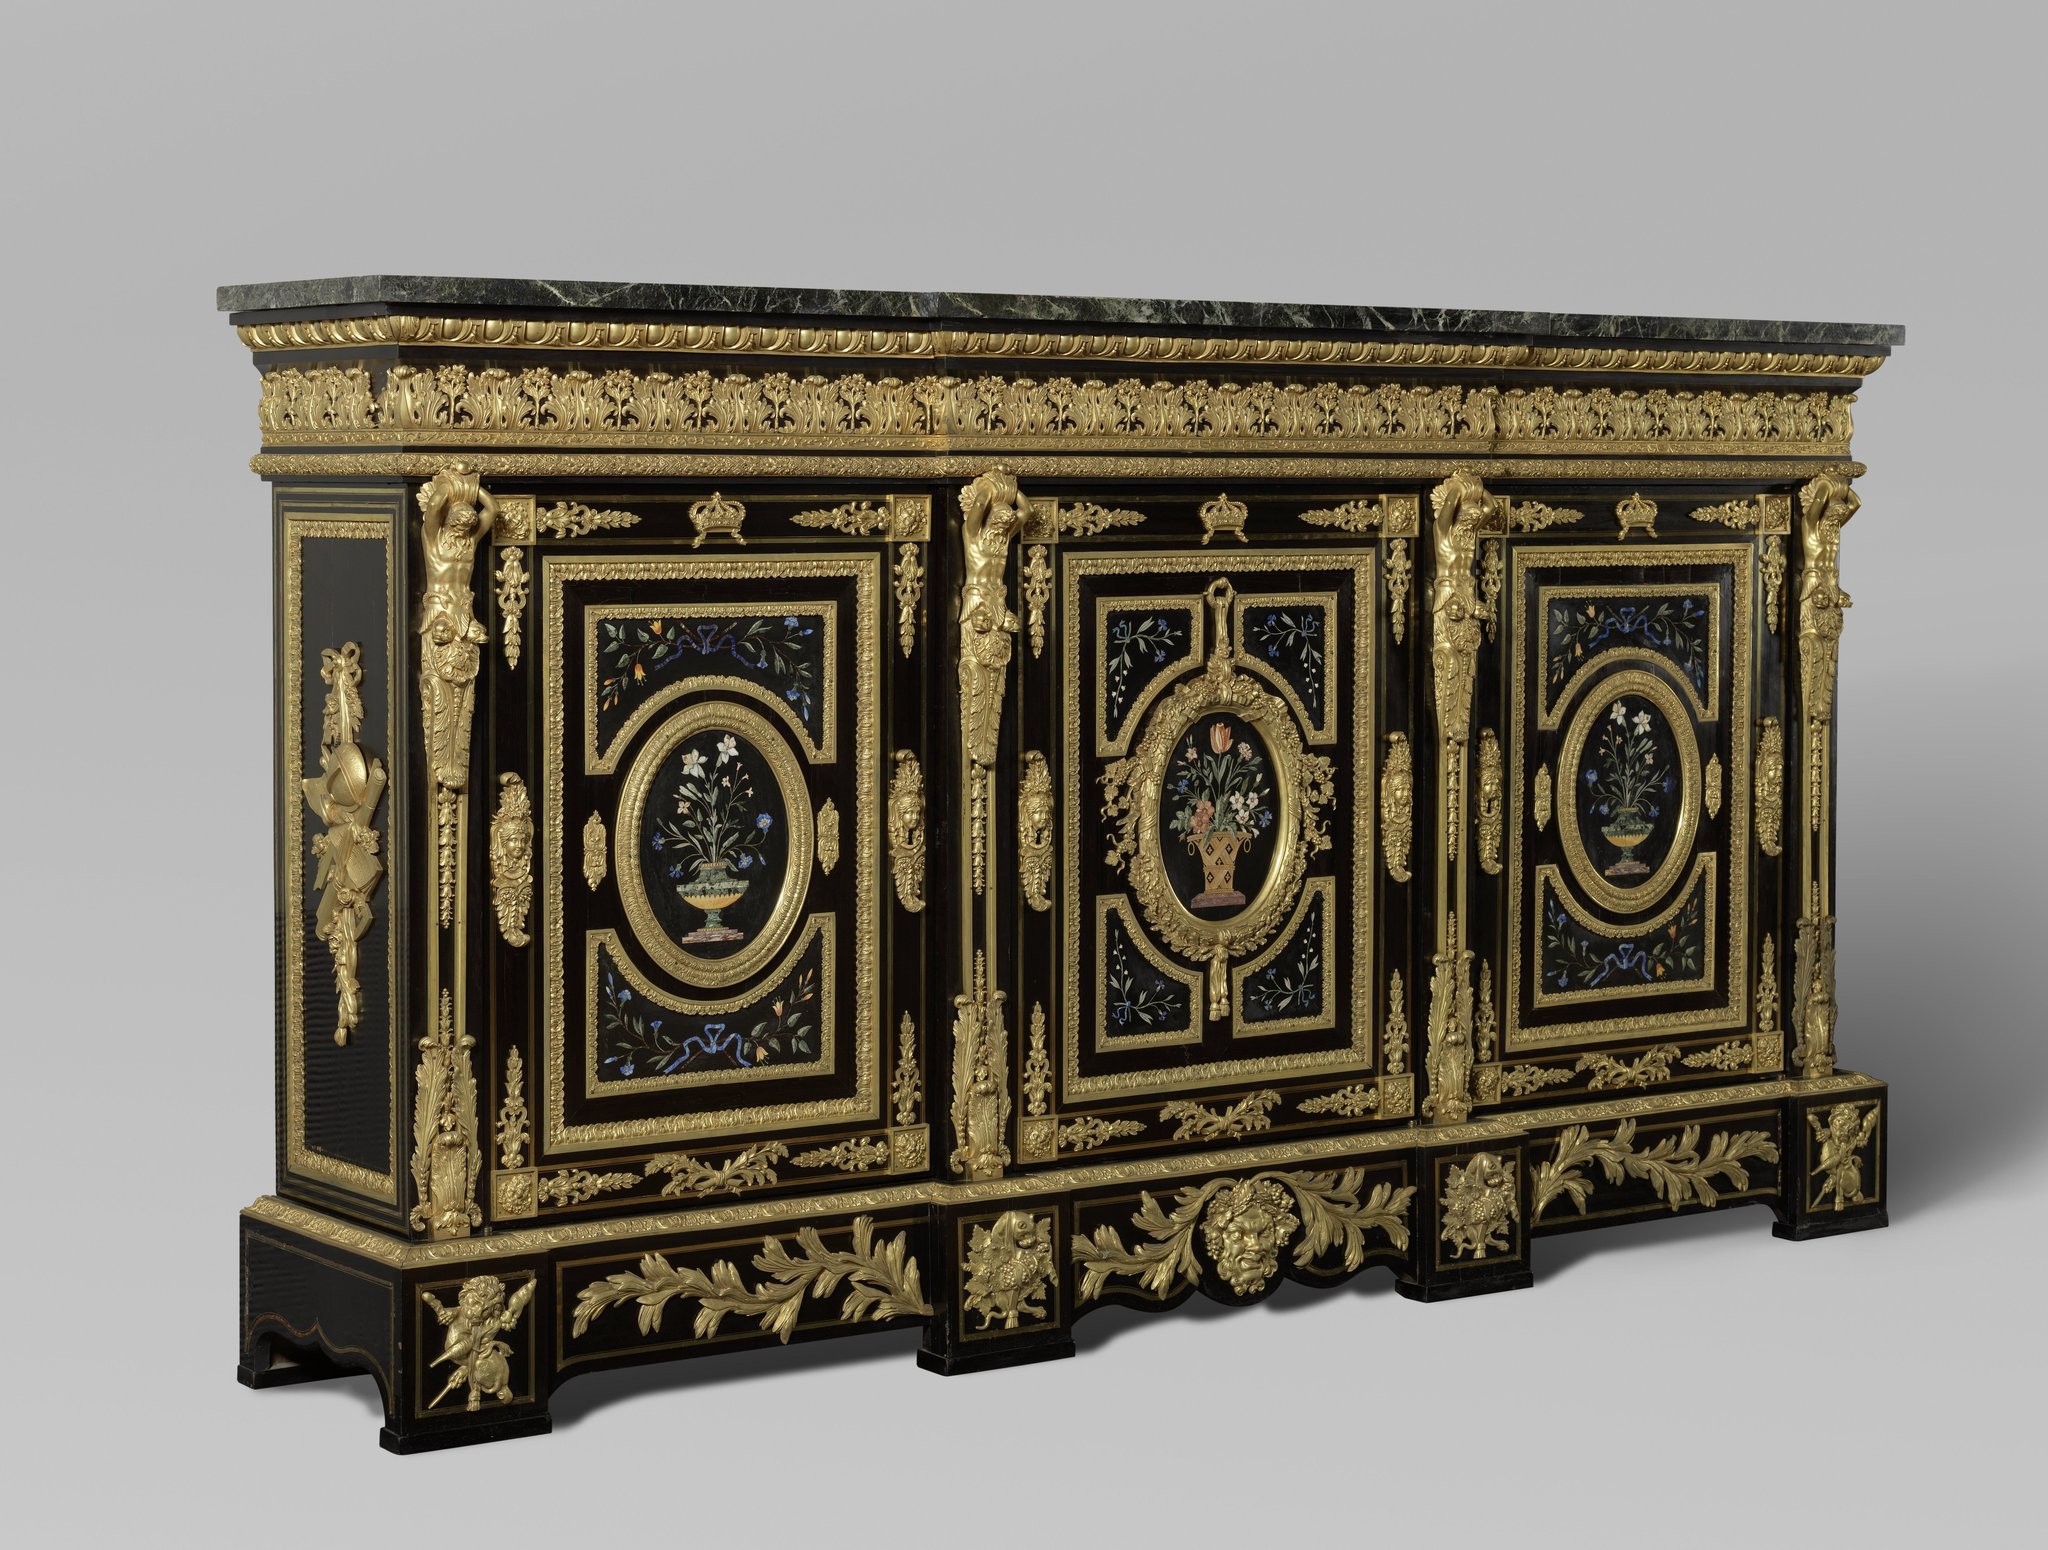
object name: case furniture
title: Three-door cabinet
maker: Anonymous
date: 1835-1838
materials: bronze, wood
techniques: gilding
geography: paris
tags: flowers in a vase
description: This cabinet was once owned by King William II. A French cabinetmaker fitted the piece with hardstone panels inlaid with floral motifs made of costly polished stones. This pietra dura technique dates from at least the 16th century. The many gilt-bronze figures and the cabinet’s robust model, however, are typical of the 19th century.